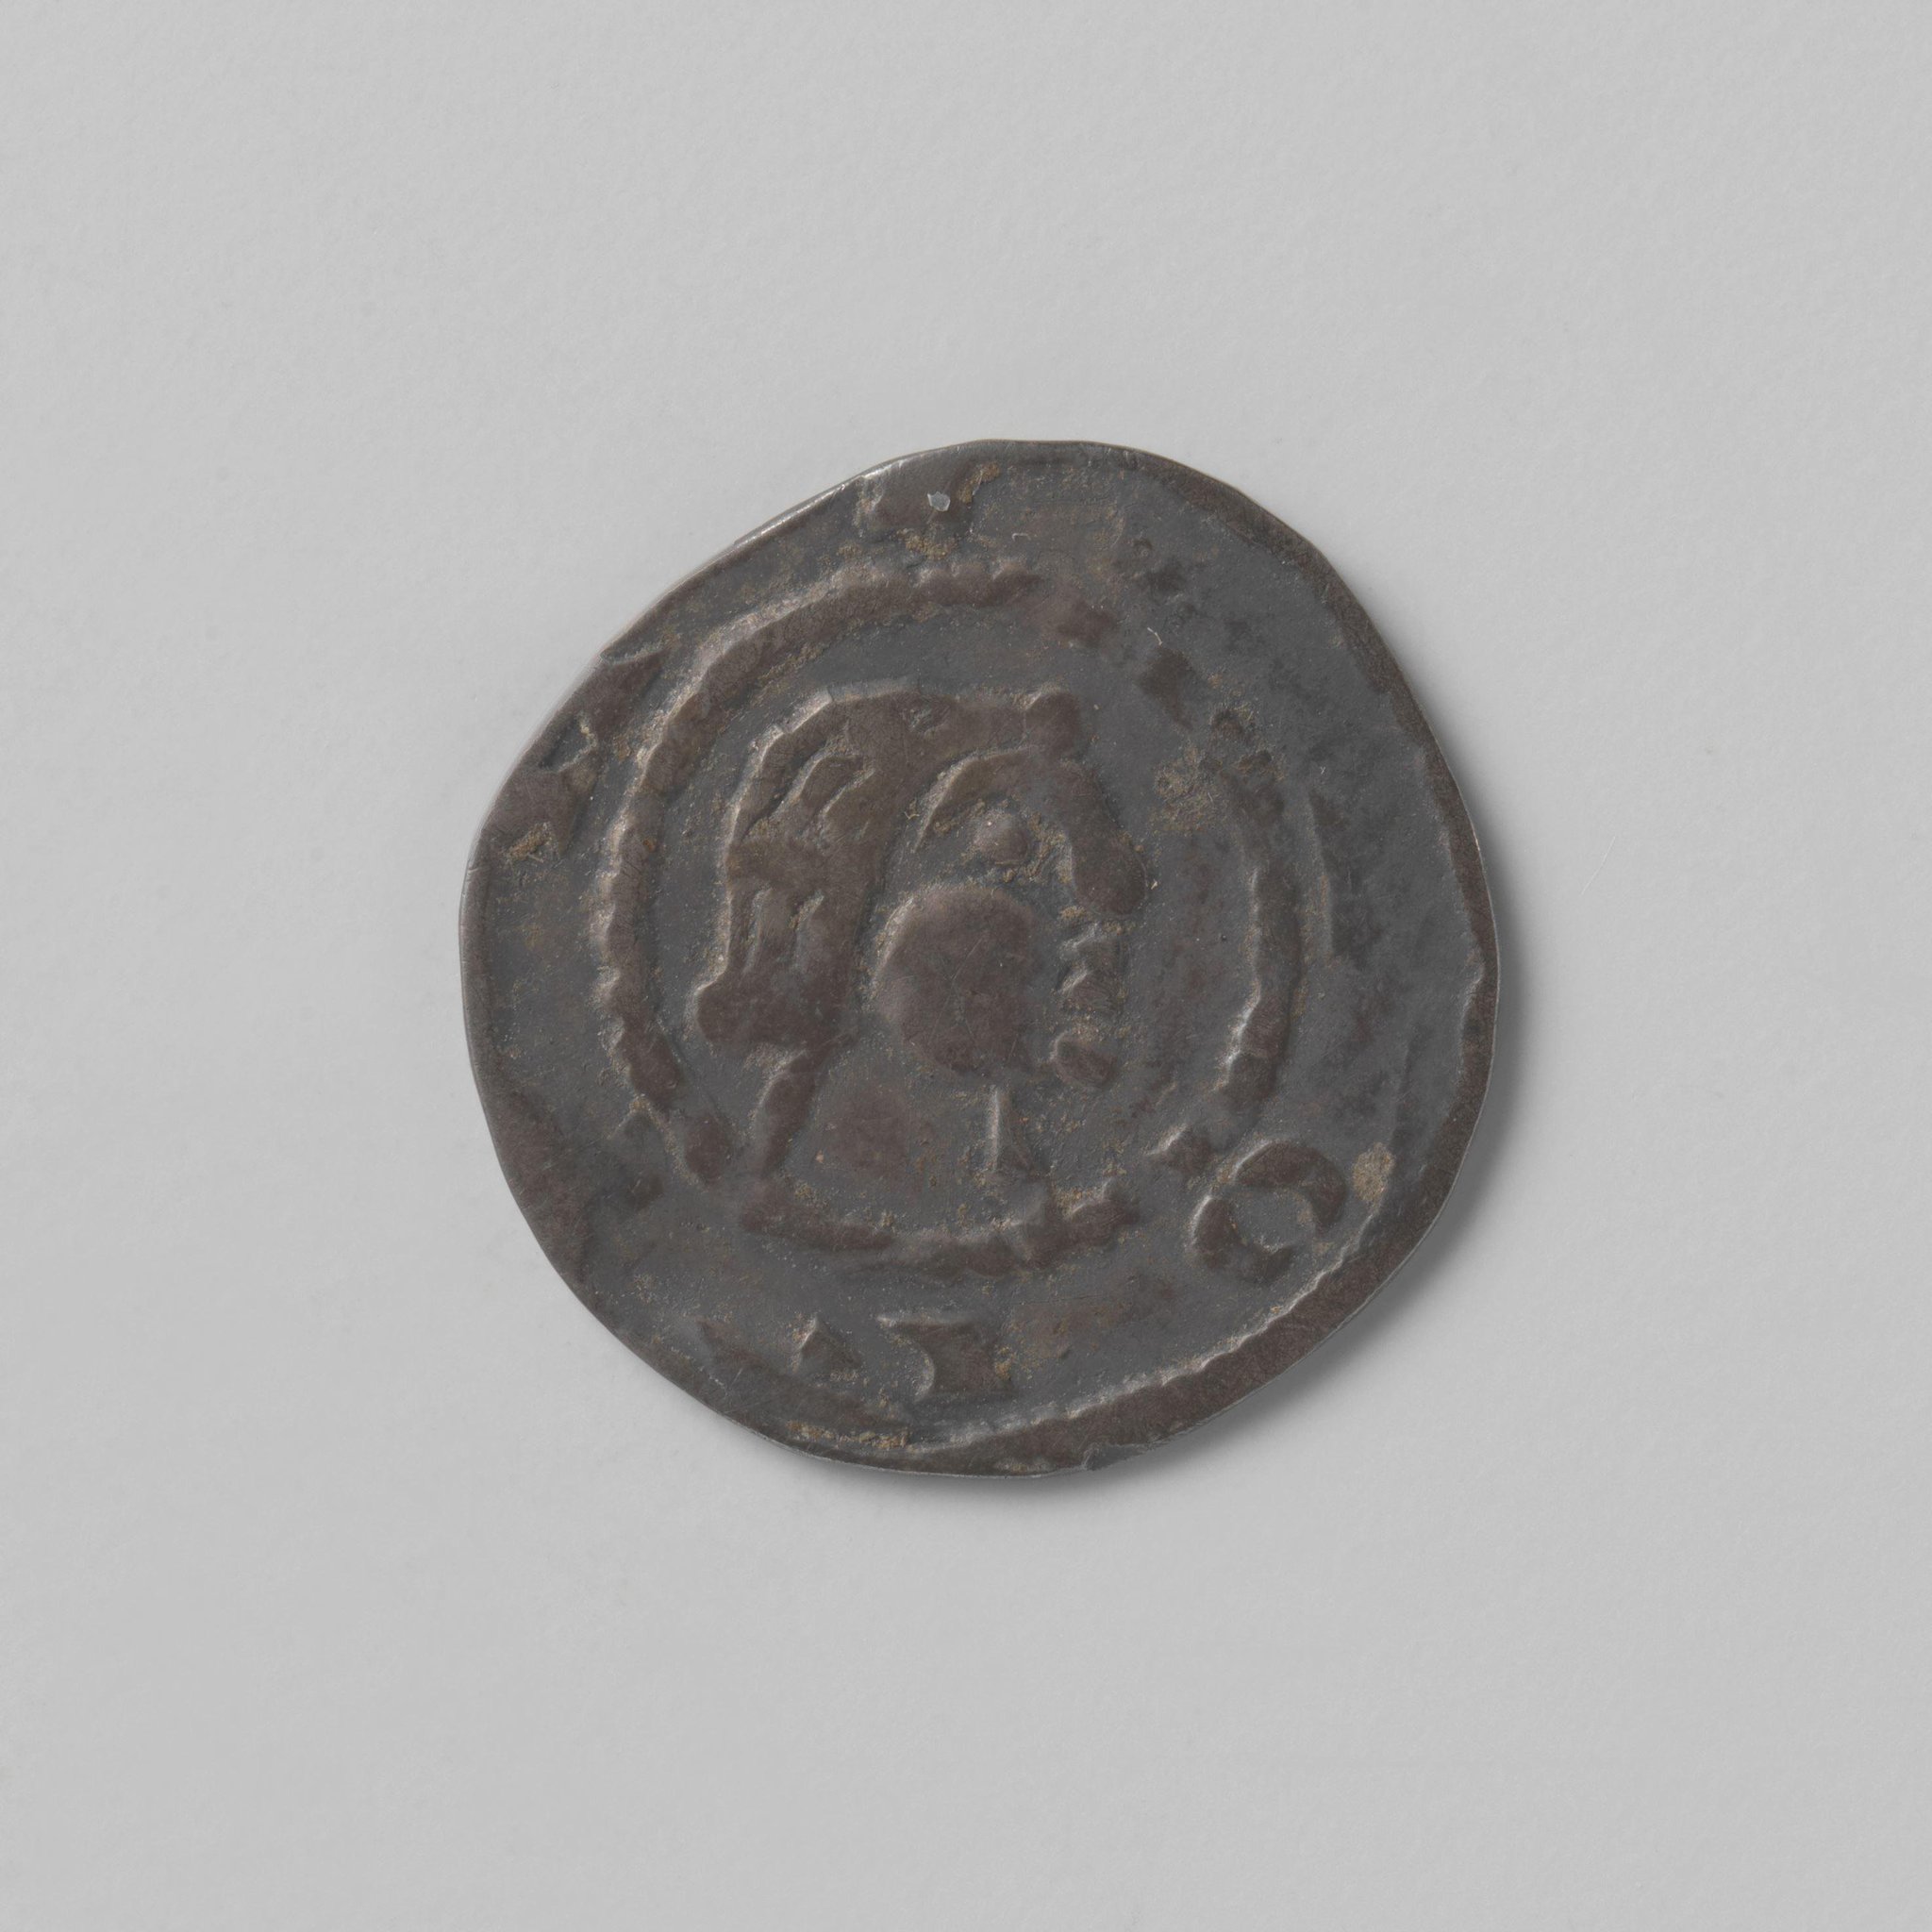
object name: penny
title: Hollandse penning van Floris V, 1256-1296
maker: floris v (graaf van holland en zeeland)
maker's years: 1254-1296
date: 1275-1284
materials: silver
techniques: striking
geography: dordrecht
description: Zilveren munt. Voorzijde: hoofd met gravenmuts naar rechts. Keerzijde: lang dubbellijnig kruis.